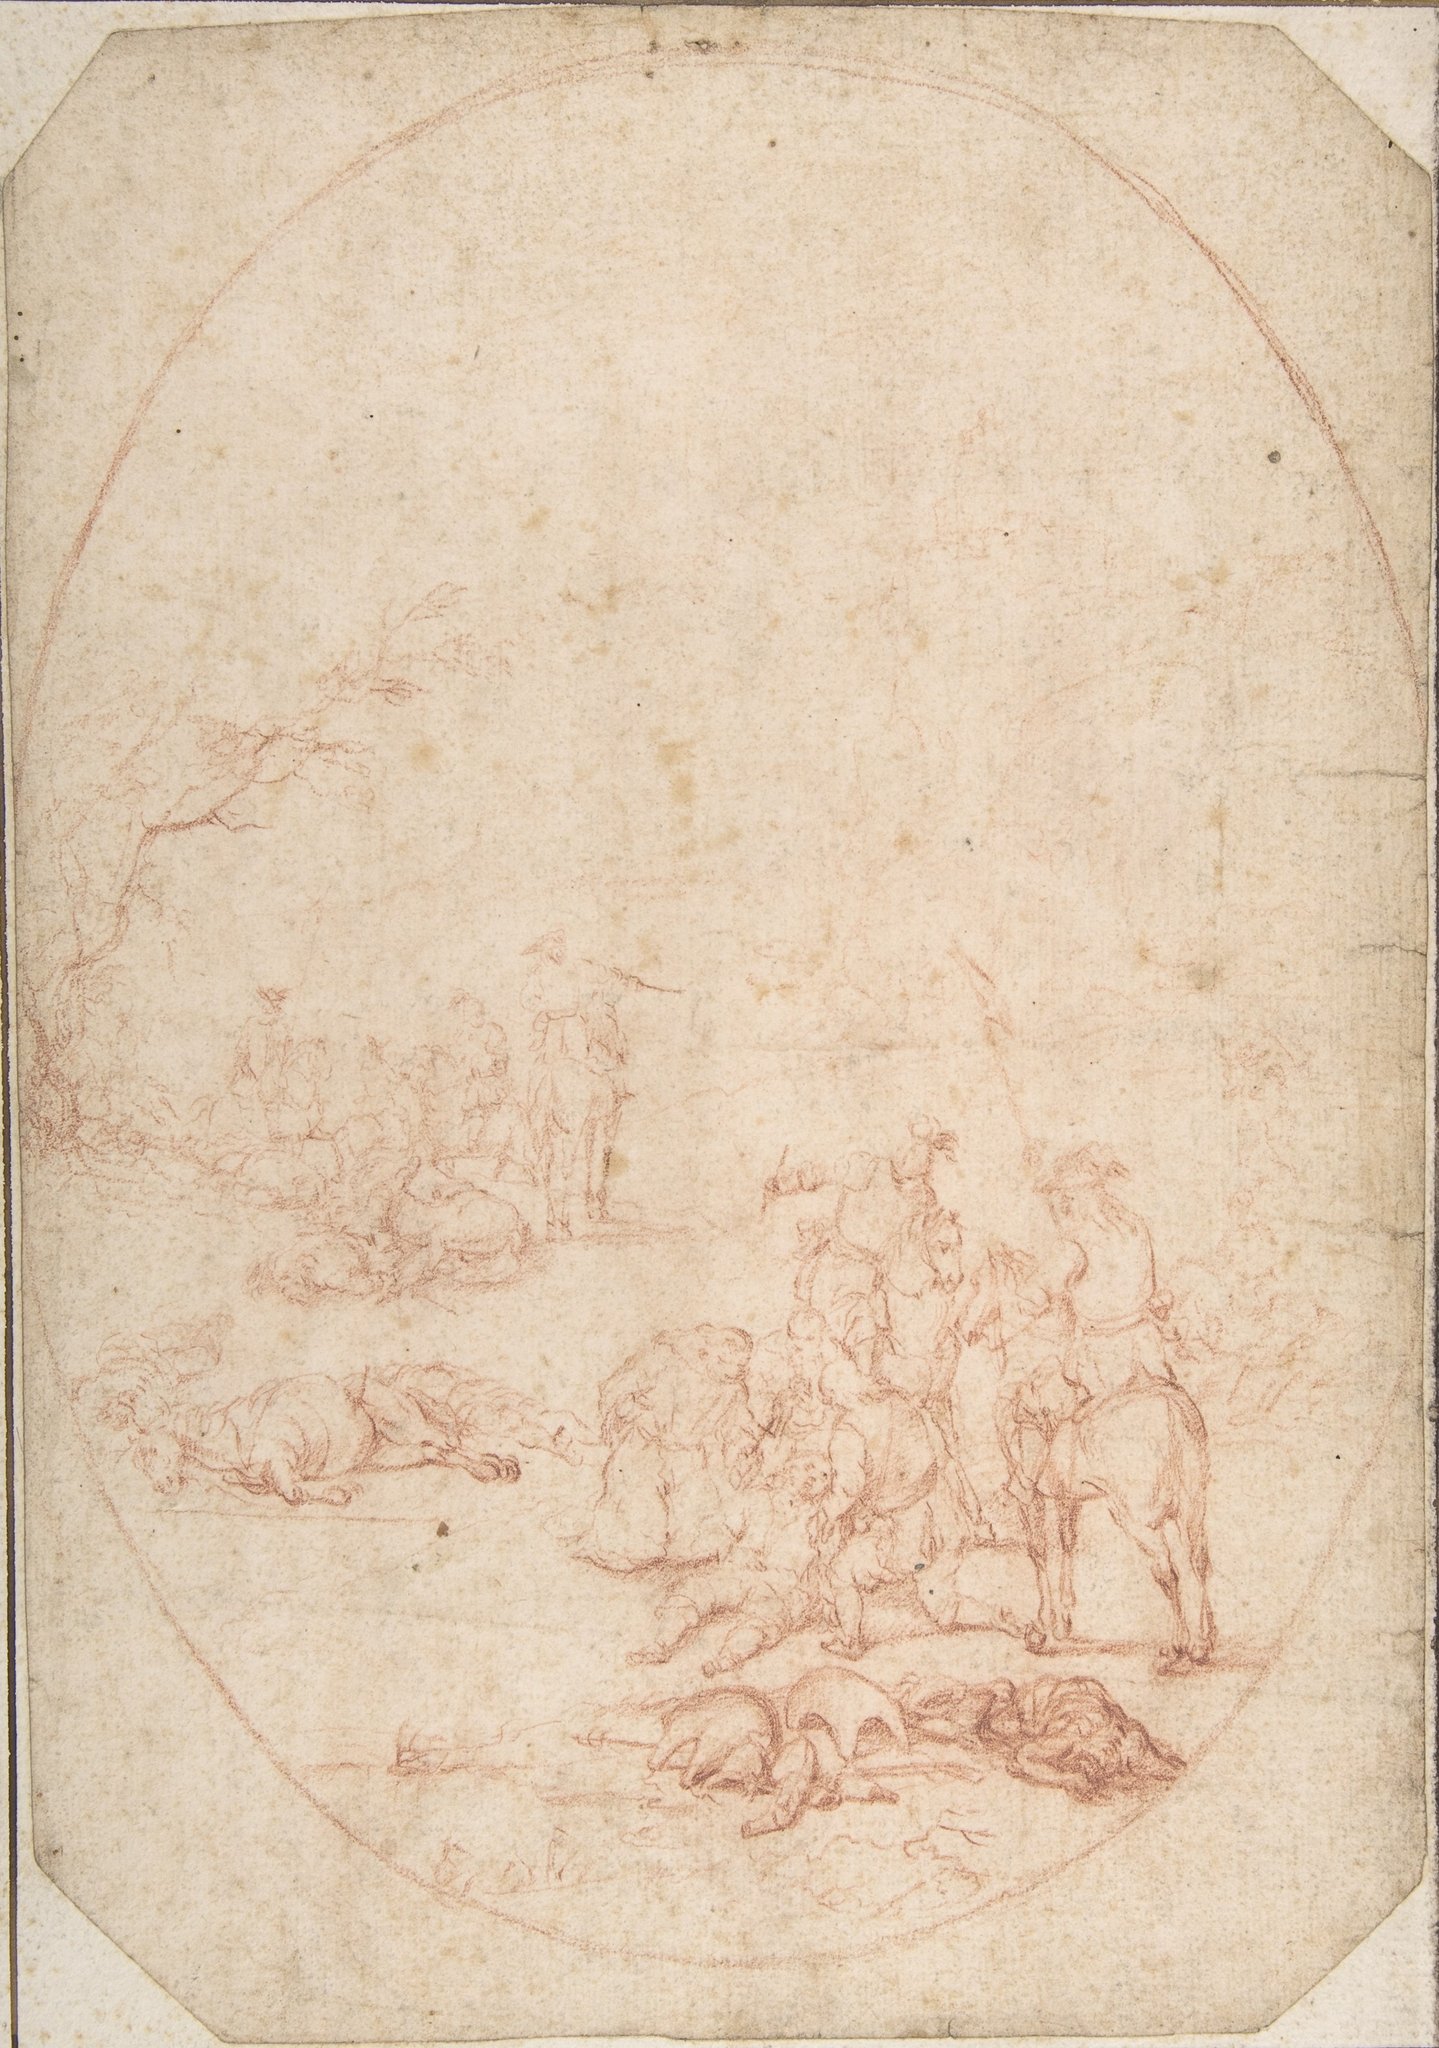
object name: drawing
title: Landscape with Soldiers Helping the Wounded after a Battle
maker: anonymous, french, 18th century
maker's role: artist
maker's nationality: french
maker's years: 1700-1800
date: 1601-1700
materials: chalk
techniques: pen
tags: soldiers,suffering,horses,landscapes